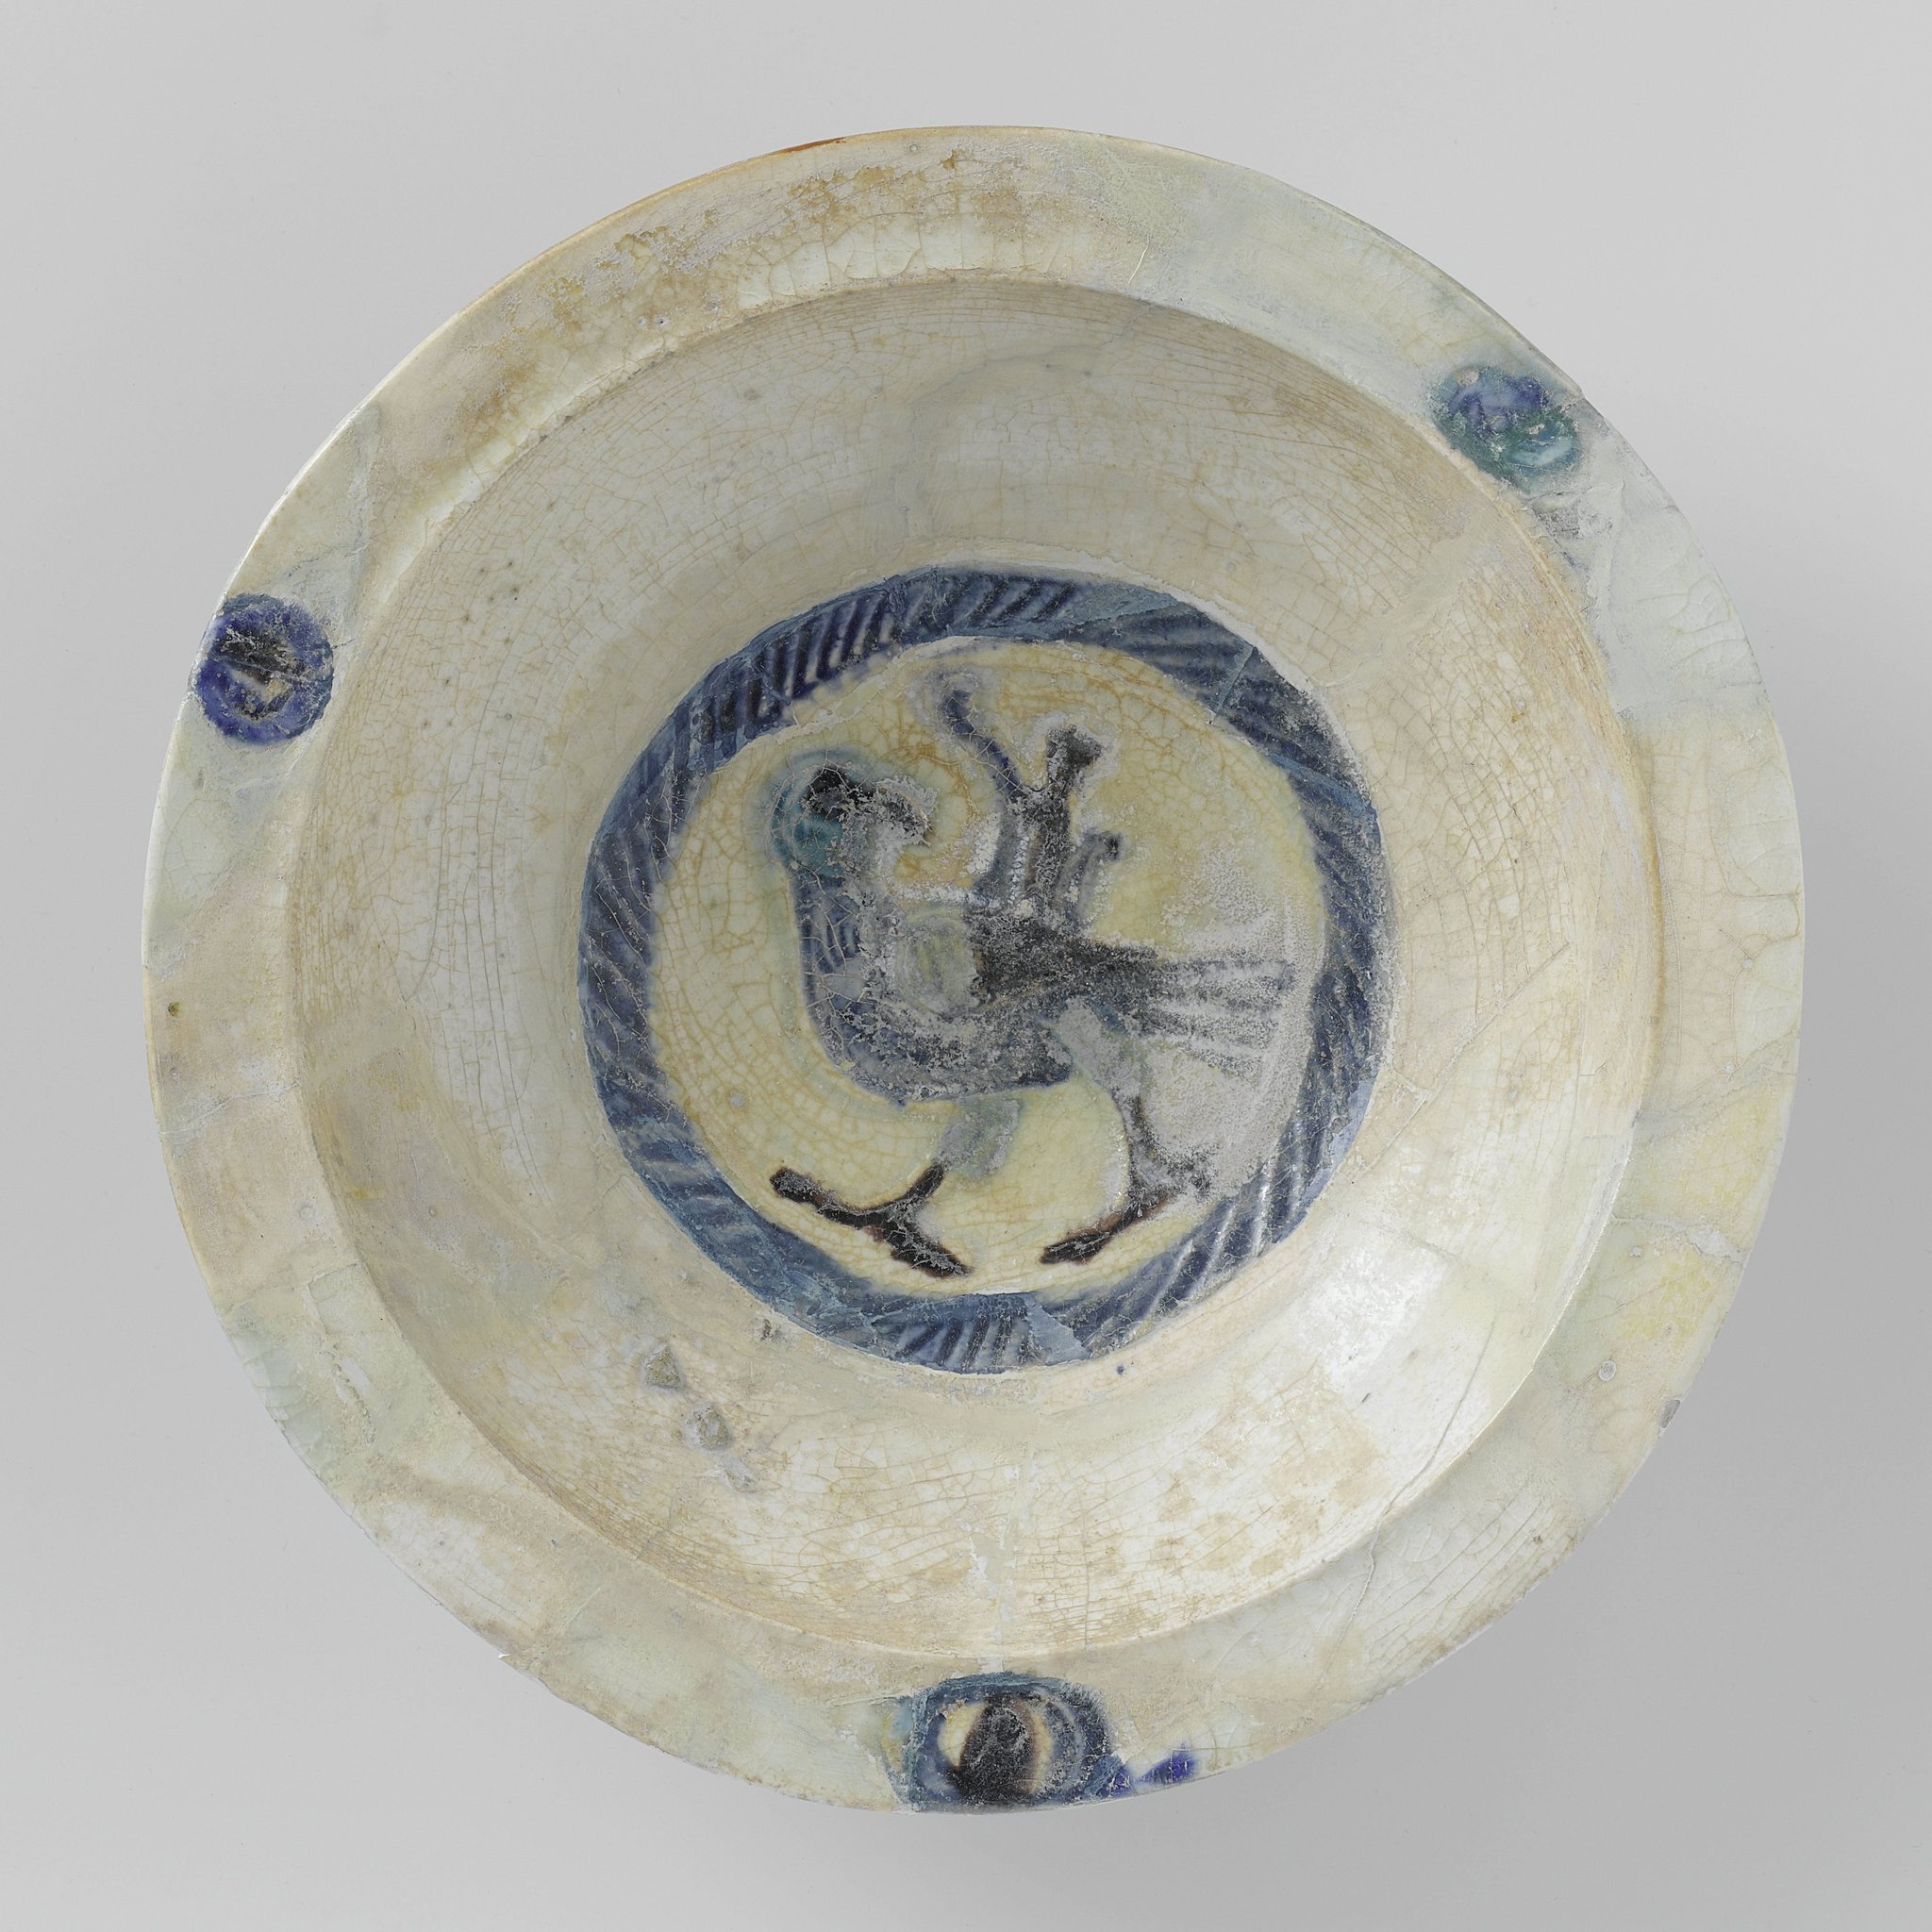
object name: dish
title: Dish with a bird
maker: Anonymous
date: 1100-1199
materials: earthenware, glaze, paint, quartz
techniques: firing, turning, vitrification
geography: syria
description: Dish, with depiction of bird in centre. Iran, 12th century. Stone paste. Incised contours around the areas of colour prevented the colours running. This technique is known as lakabi, 'coloured'.